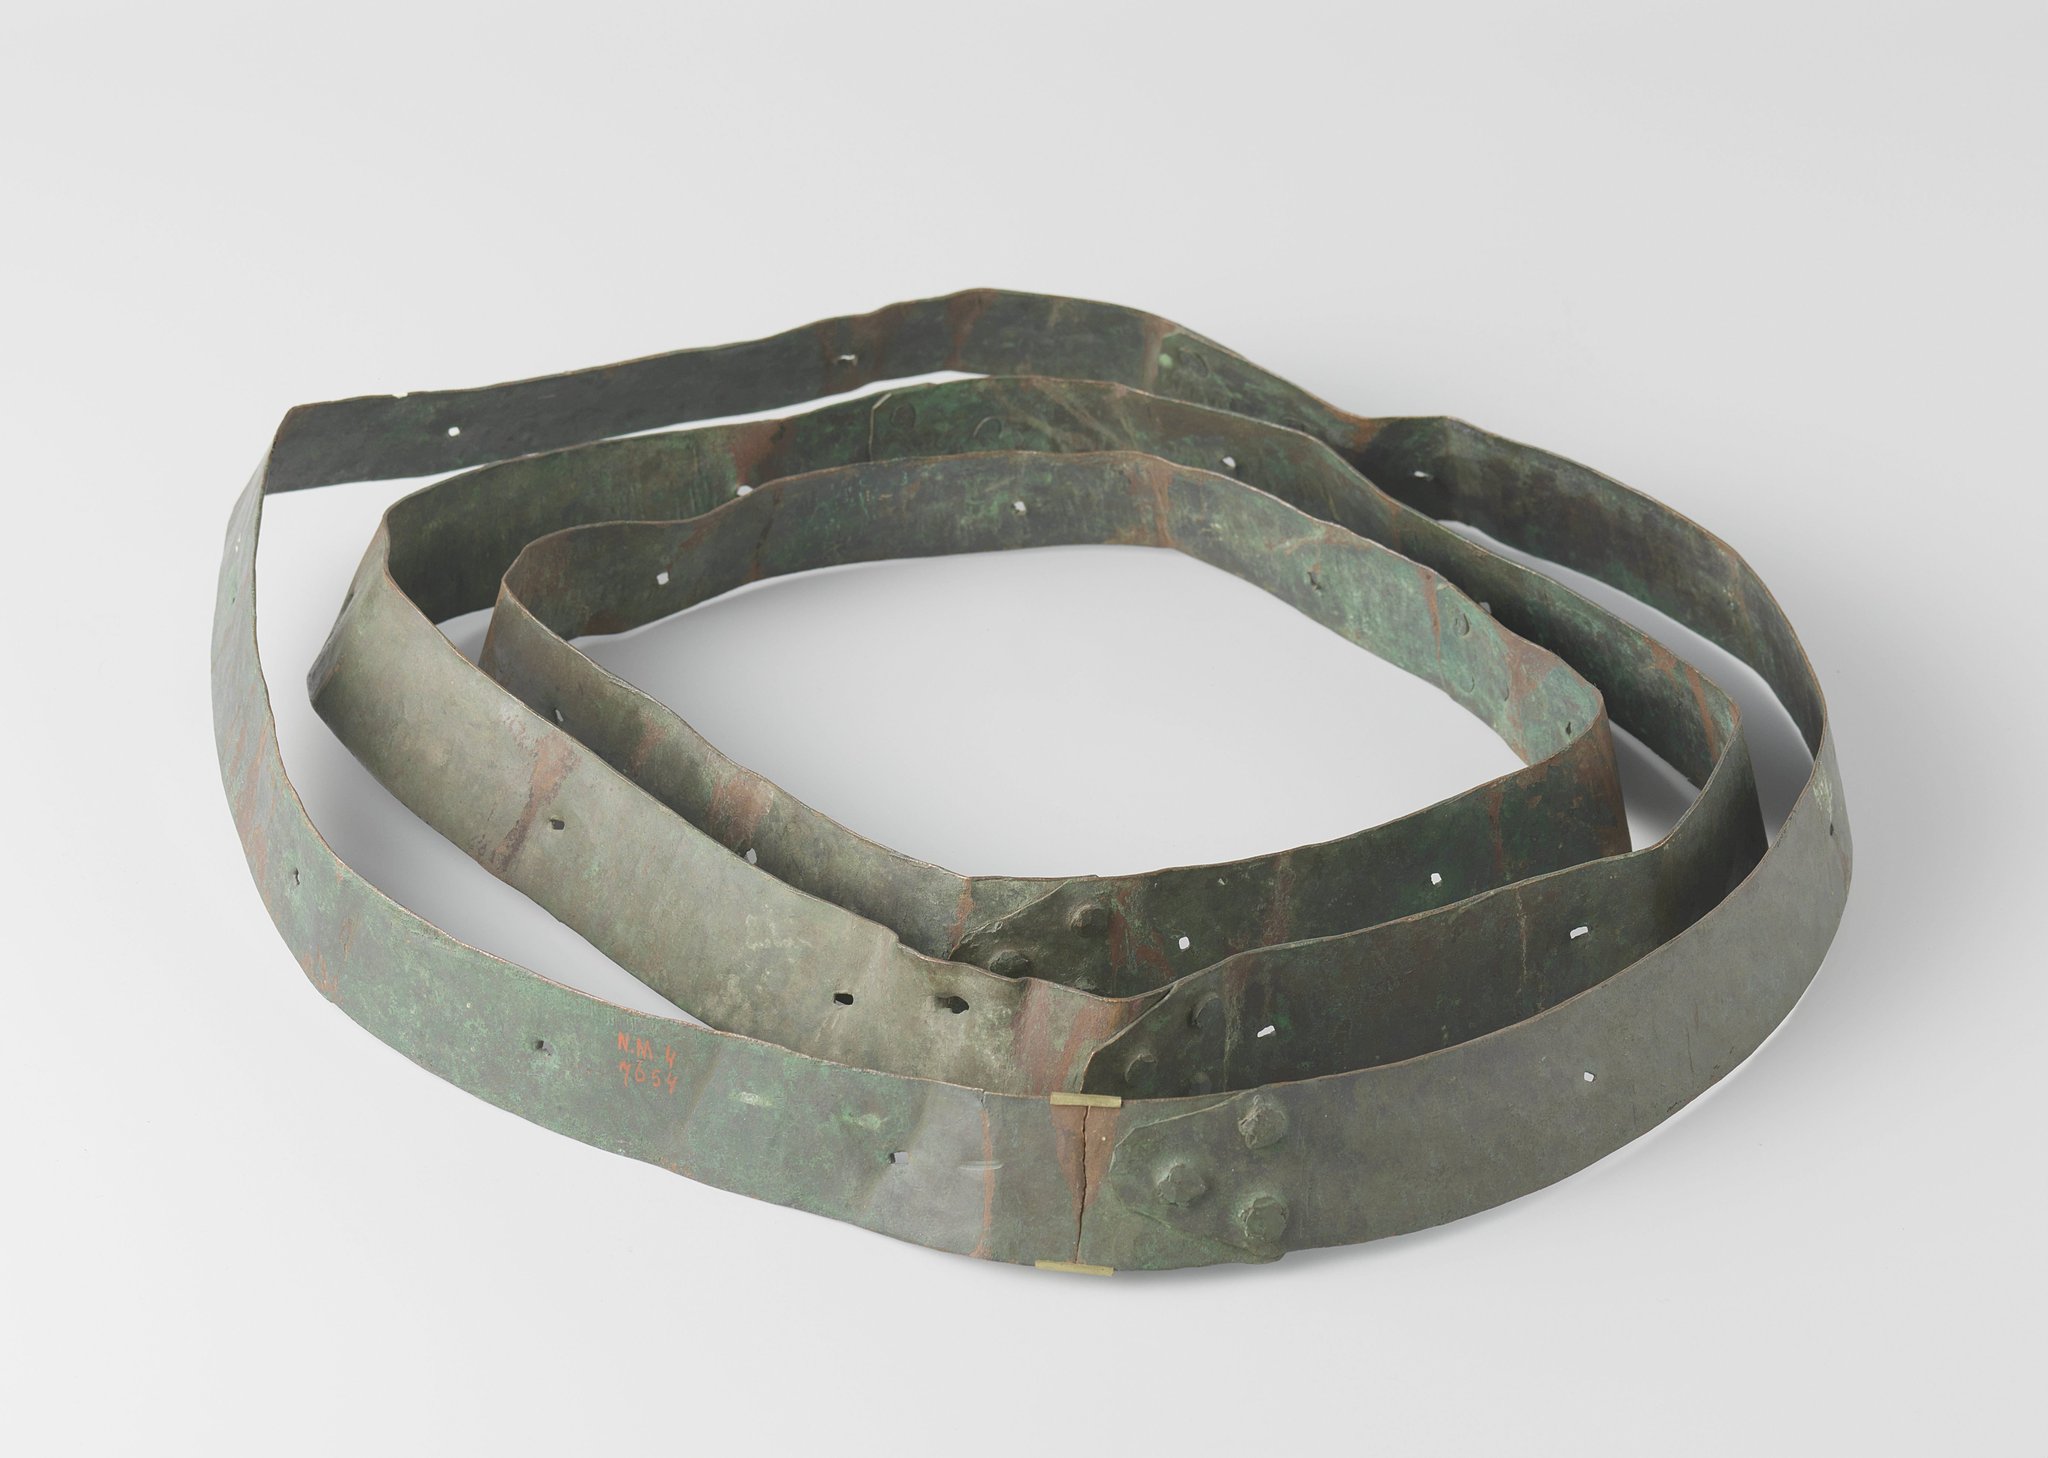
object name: ewer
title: Koperen beslagband, onderdeel van een houten schenkkan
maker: Anonymous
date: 1590-1596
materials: copper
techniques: striking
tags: willem barendsz., amsterdam, jacob van heemskerck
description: Bronze/Copper bands and spout for a wooden pitcher.